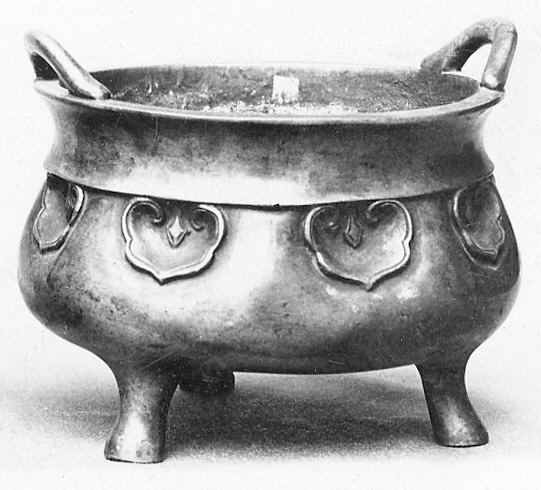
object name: incense burner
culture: japanese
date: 1801-1900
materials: bronze